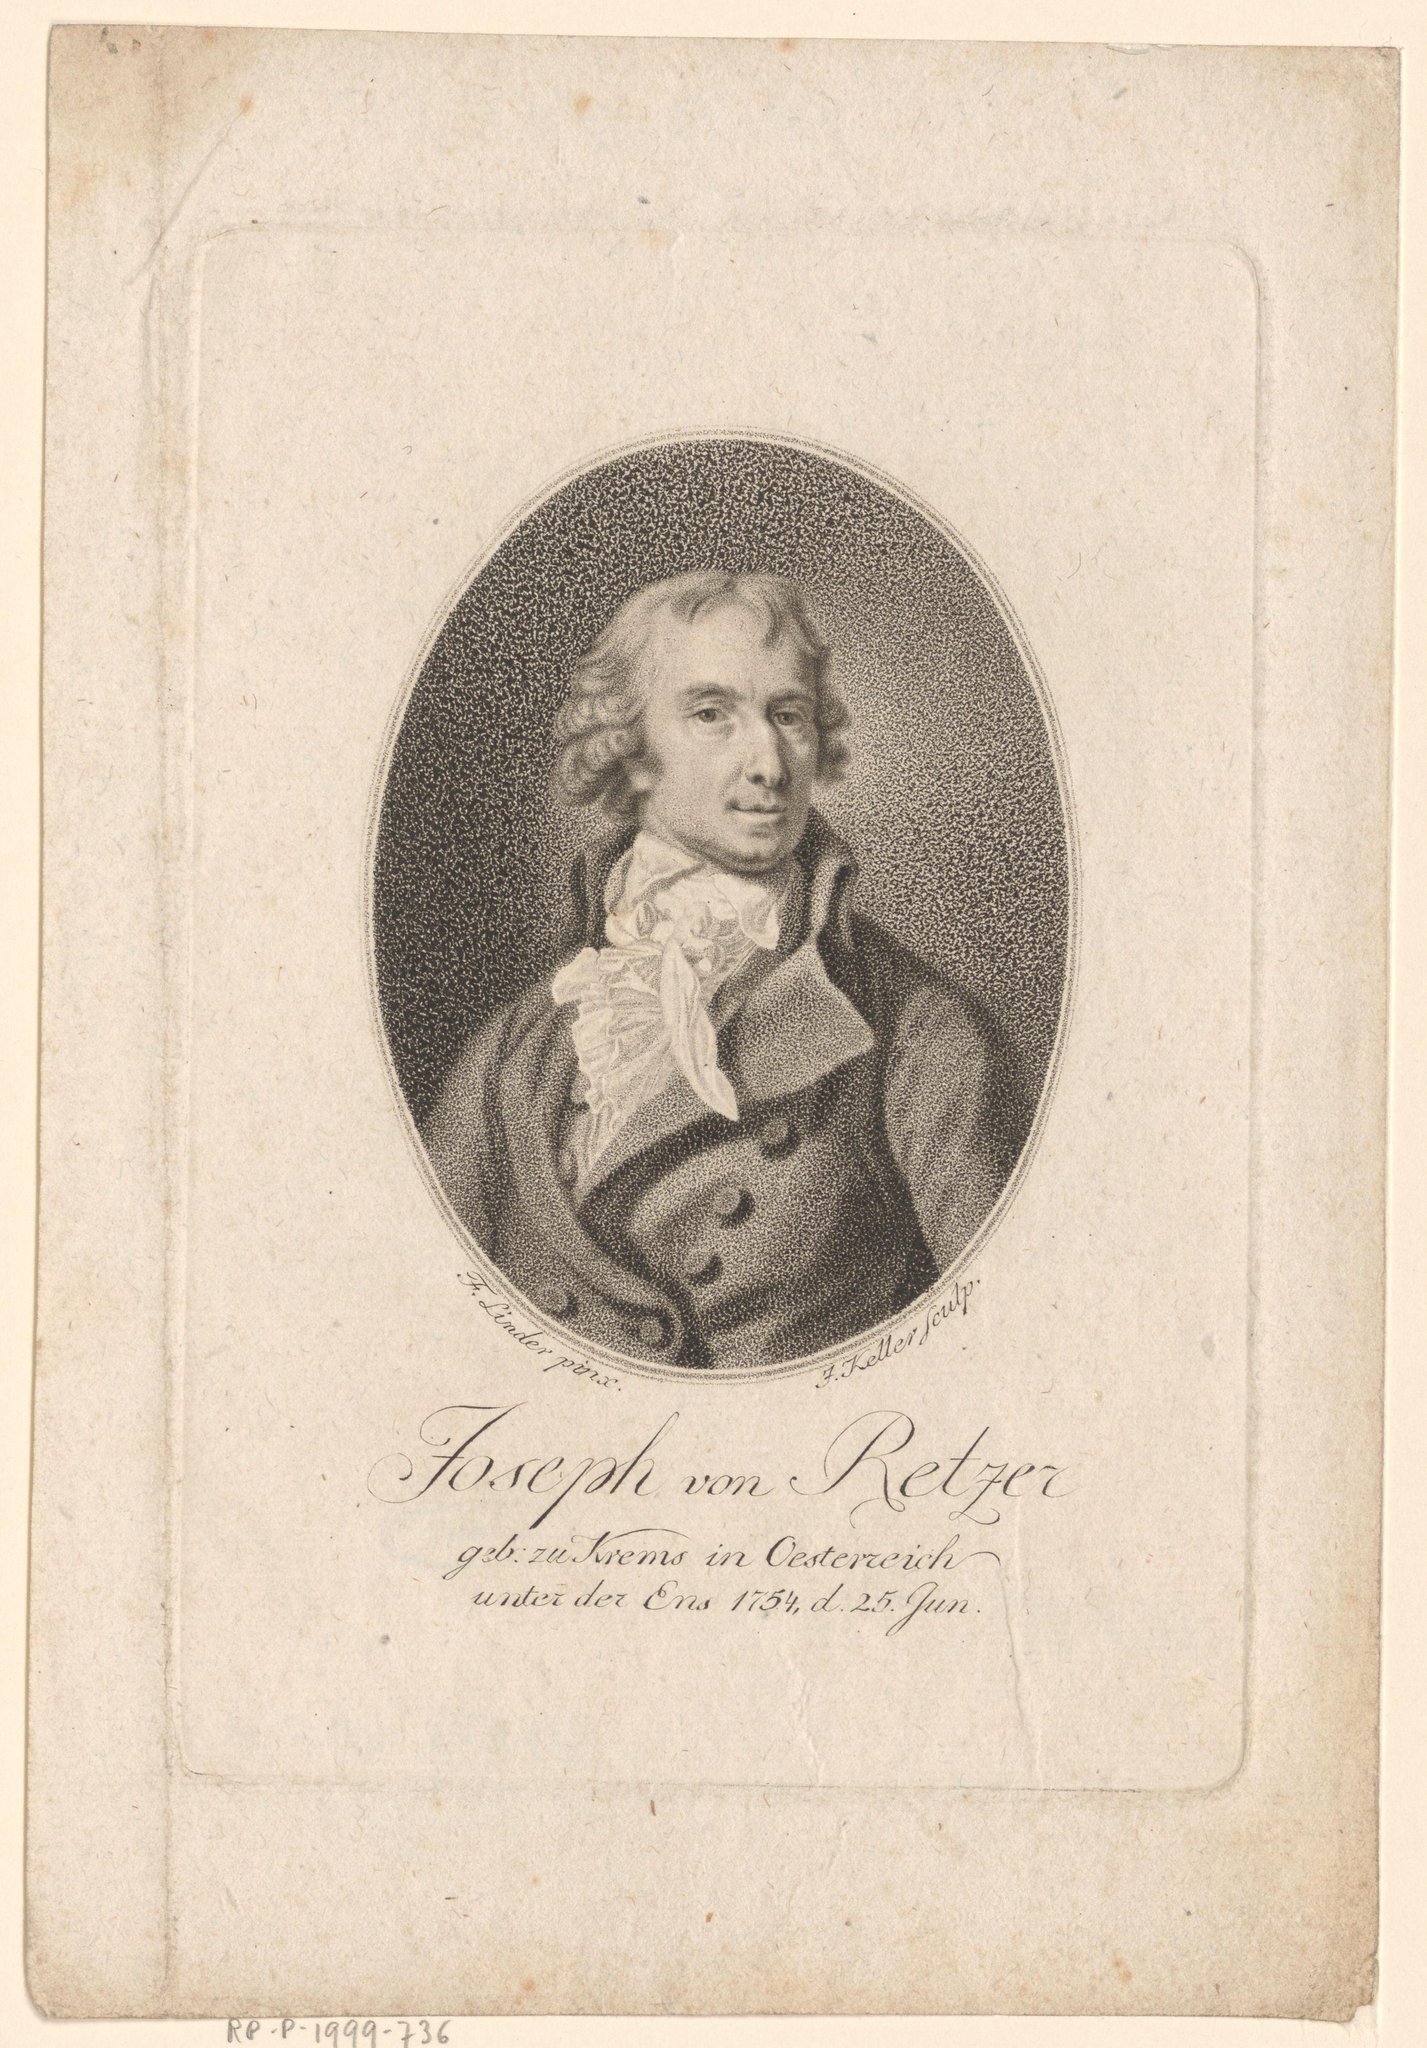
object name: print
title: Portret van baron Joseph Friedrich von Retzer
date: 1799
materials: paper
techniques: engraving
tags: historical persons, portrait of a writer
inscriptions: collector's mark: Lugt 2228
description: Prent mogelijk uit: Neue Bibliothek der schönen Wissenschaften und der freyen Künste. Leipzig: Johann Gottfried Dyck II, 1799.